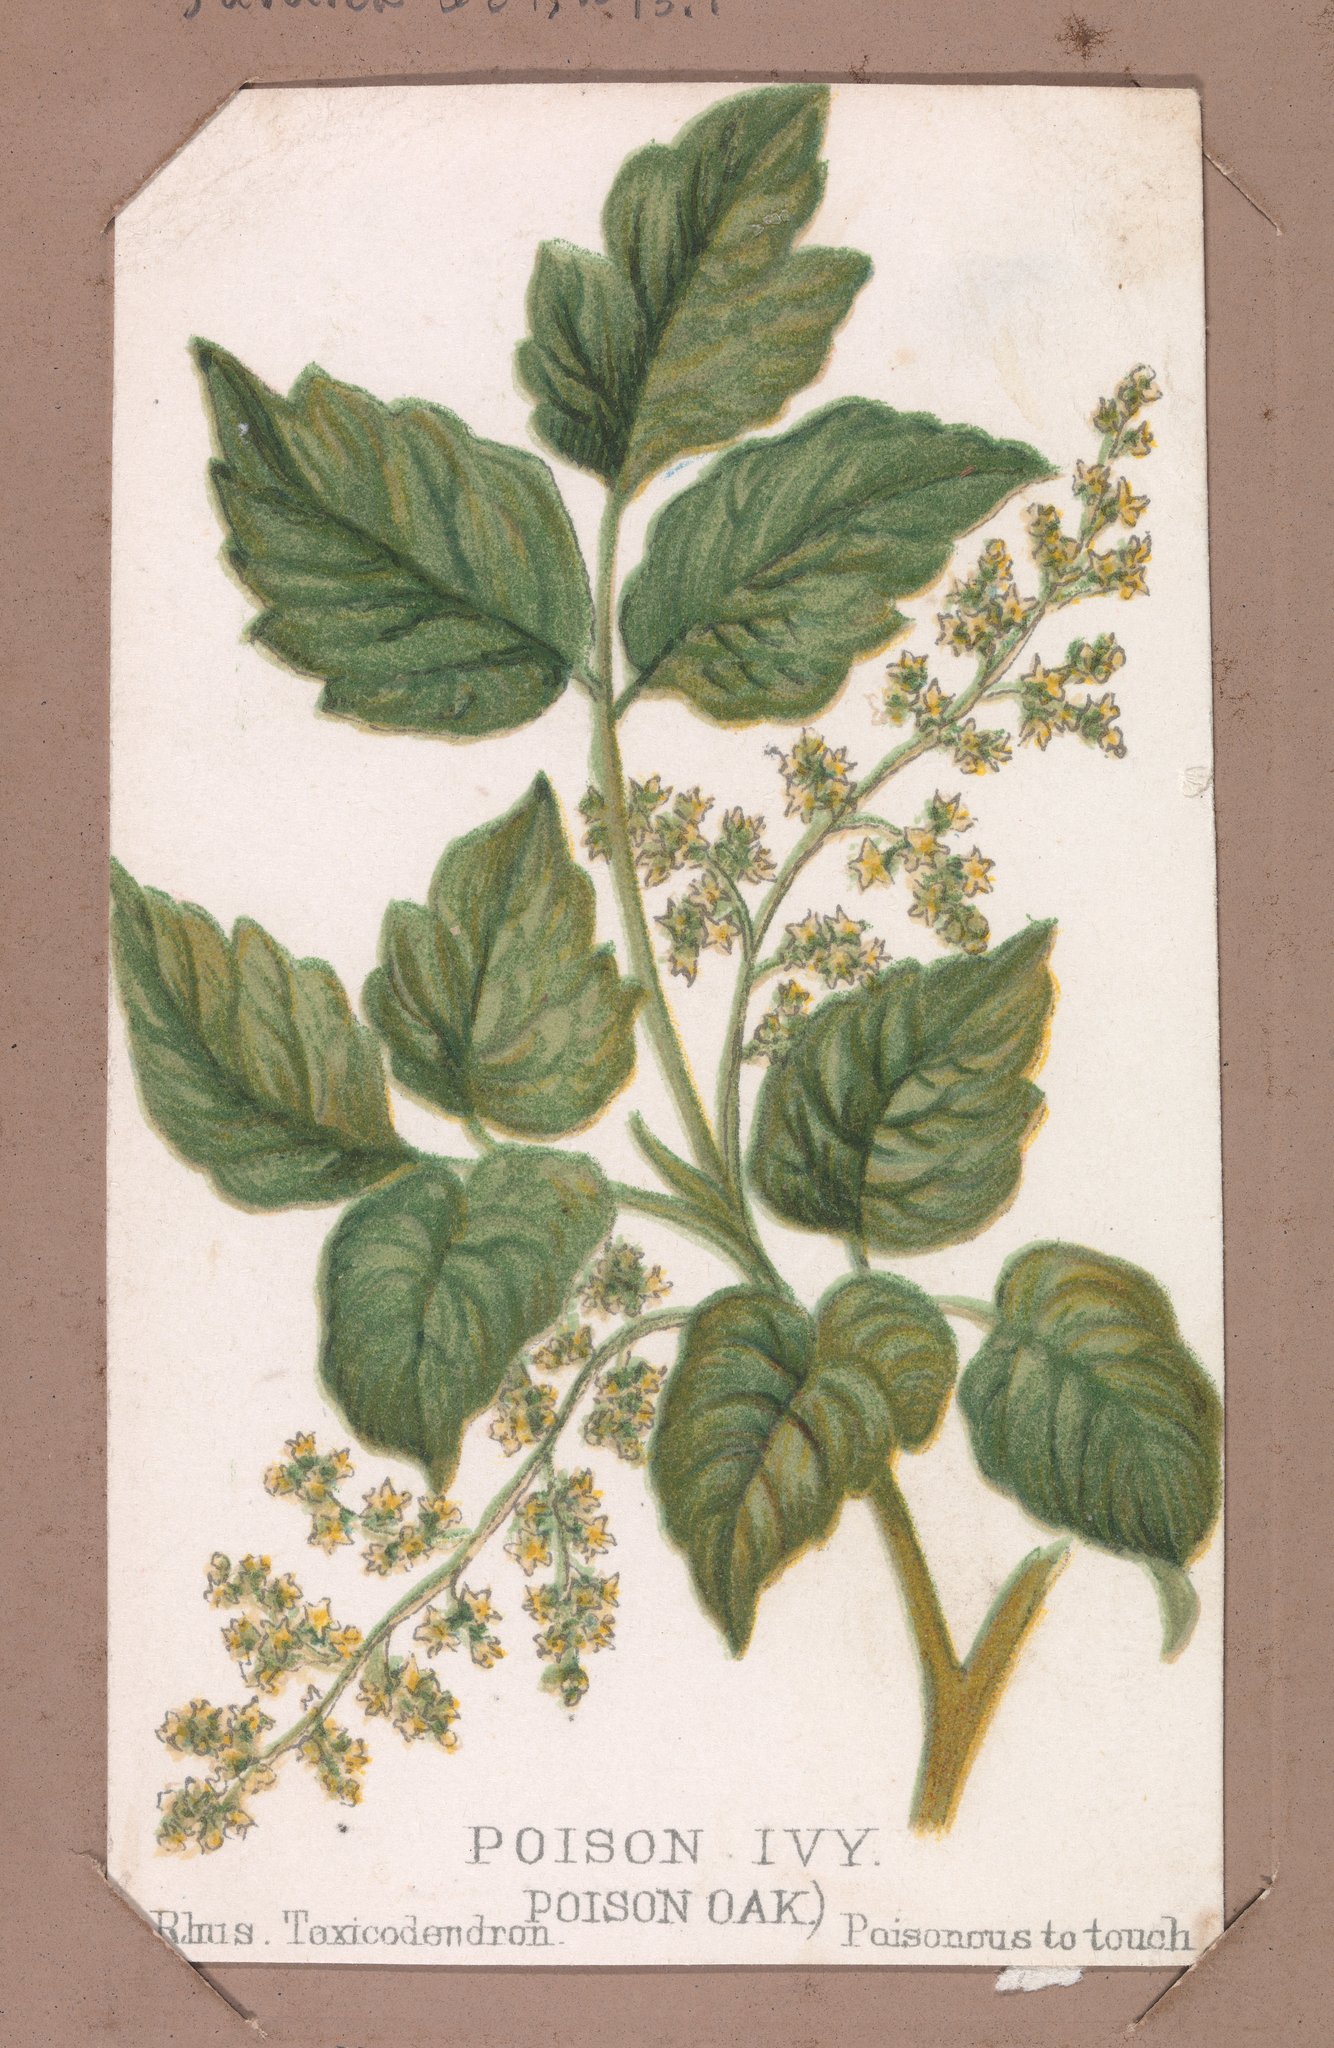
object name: album card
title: Poison Ivy from the Plants series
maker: louis prang & co.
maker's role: publisher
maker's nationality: american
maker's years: 1800-1950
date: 1862-1869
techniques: lithograph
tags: plants